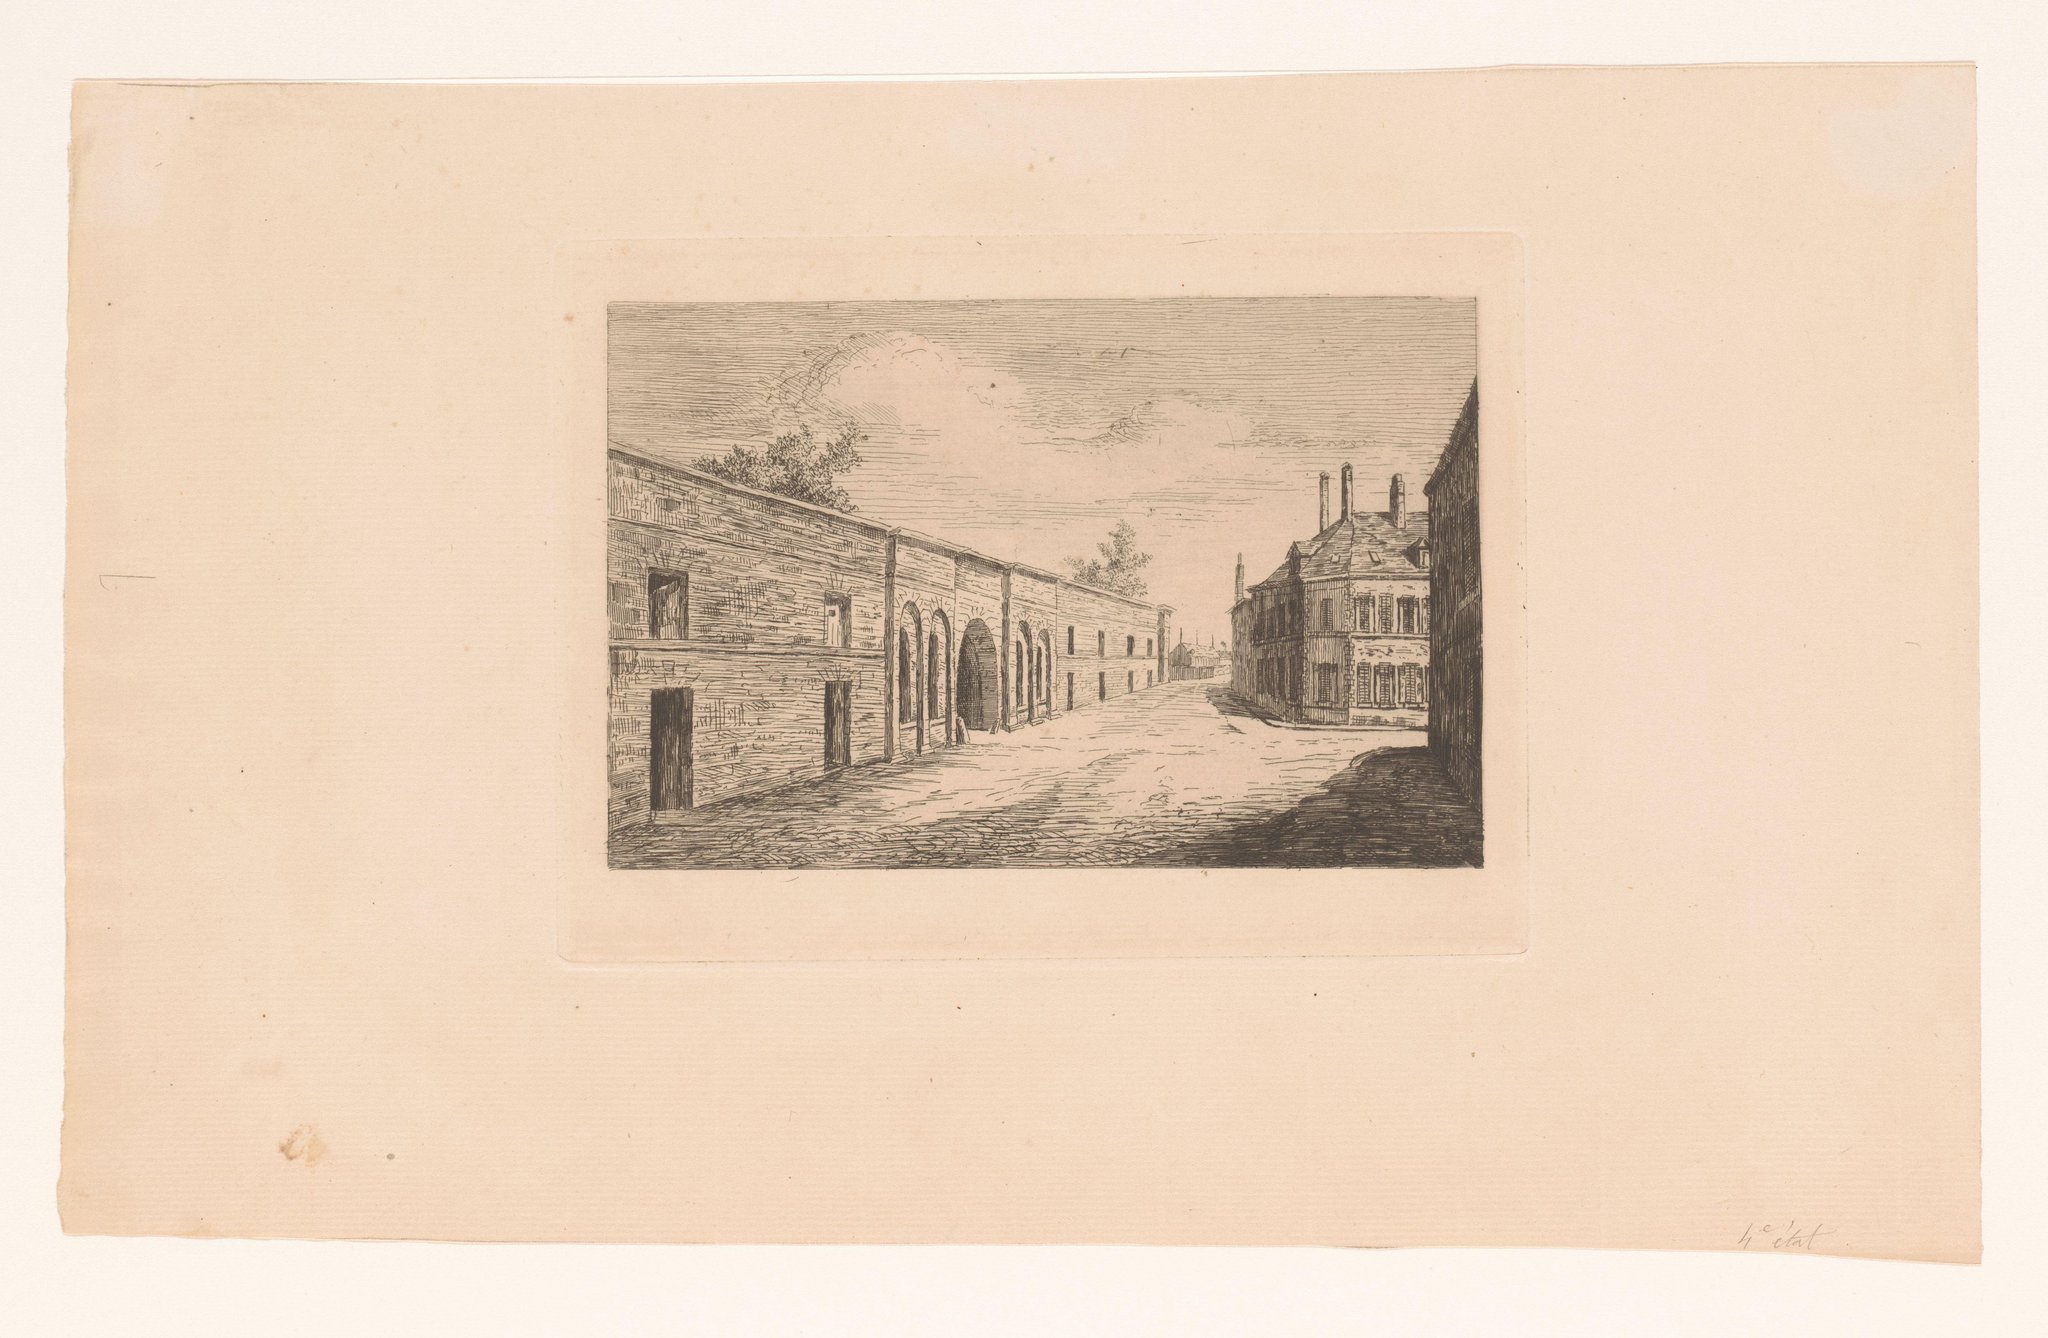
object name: print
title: Gezicht op de Porte d'Havré te Mons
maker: léon dolez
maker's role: print maker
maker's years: 1837-1902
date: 1875-1878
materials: paper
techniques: drypoint, etching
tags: village-gate, street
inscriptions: inscription: ‘4e état’, collector's mark: Lugt 2228